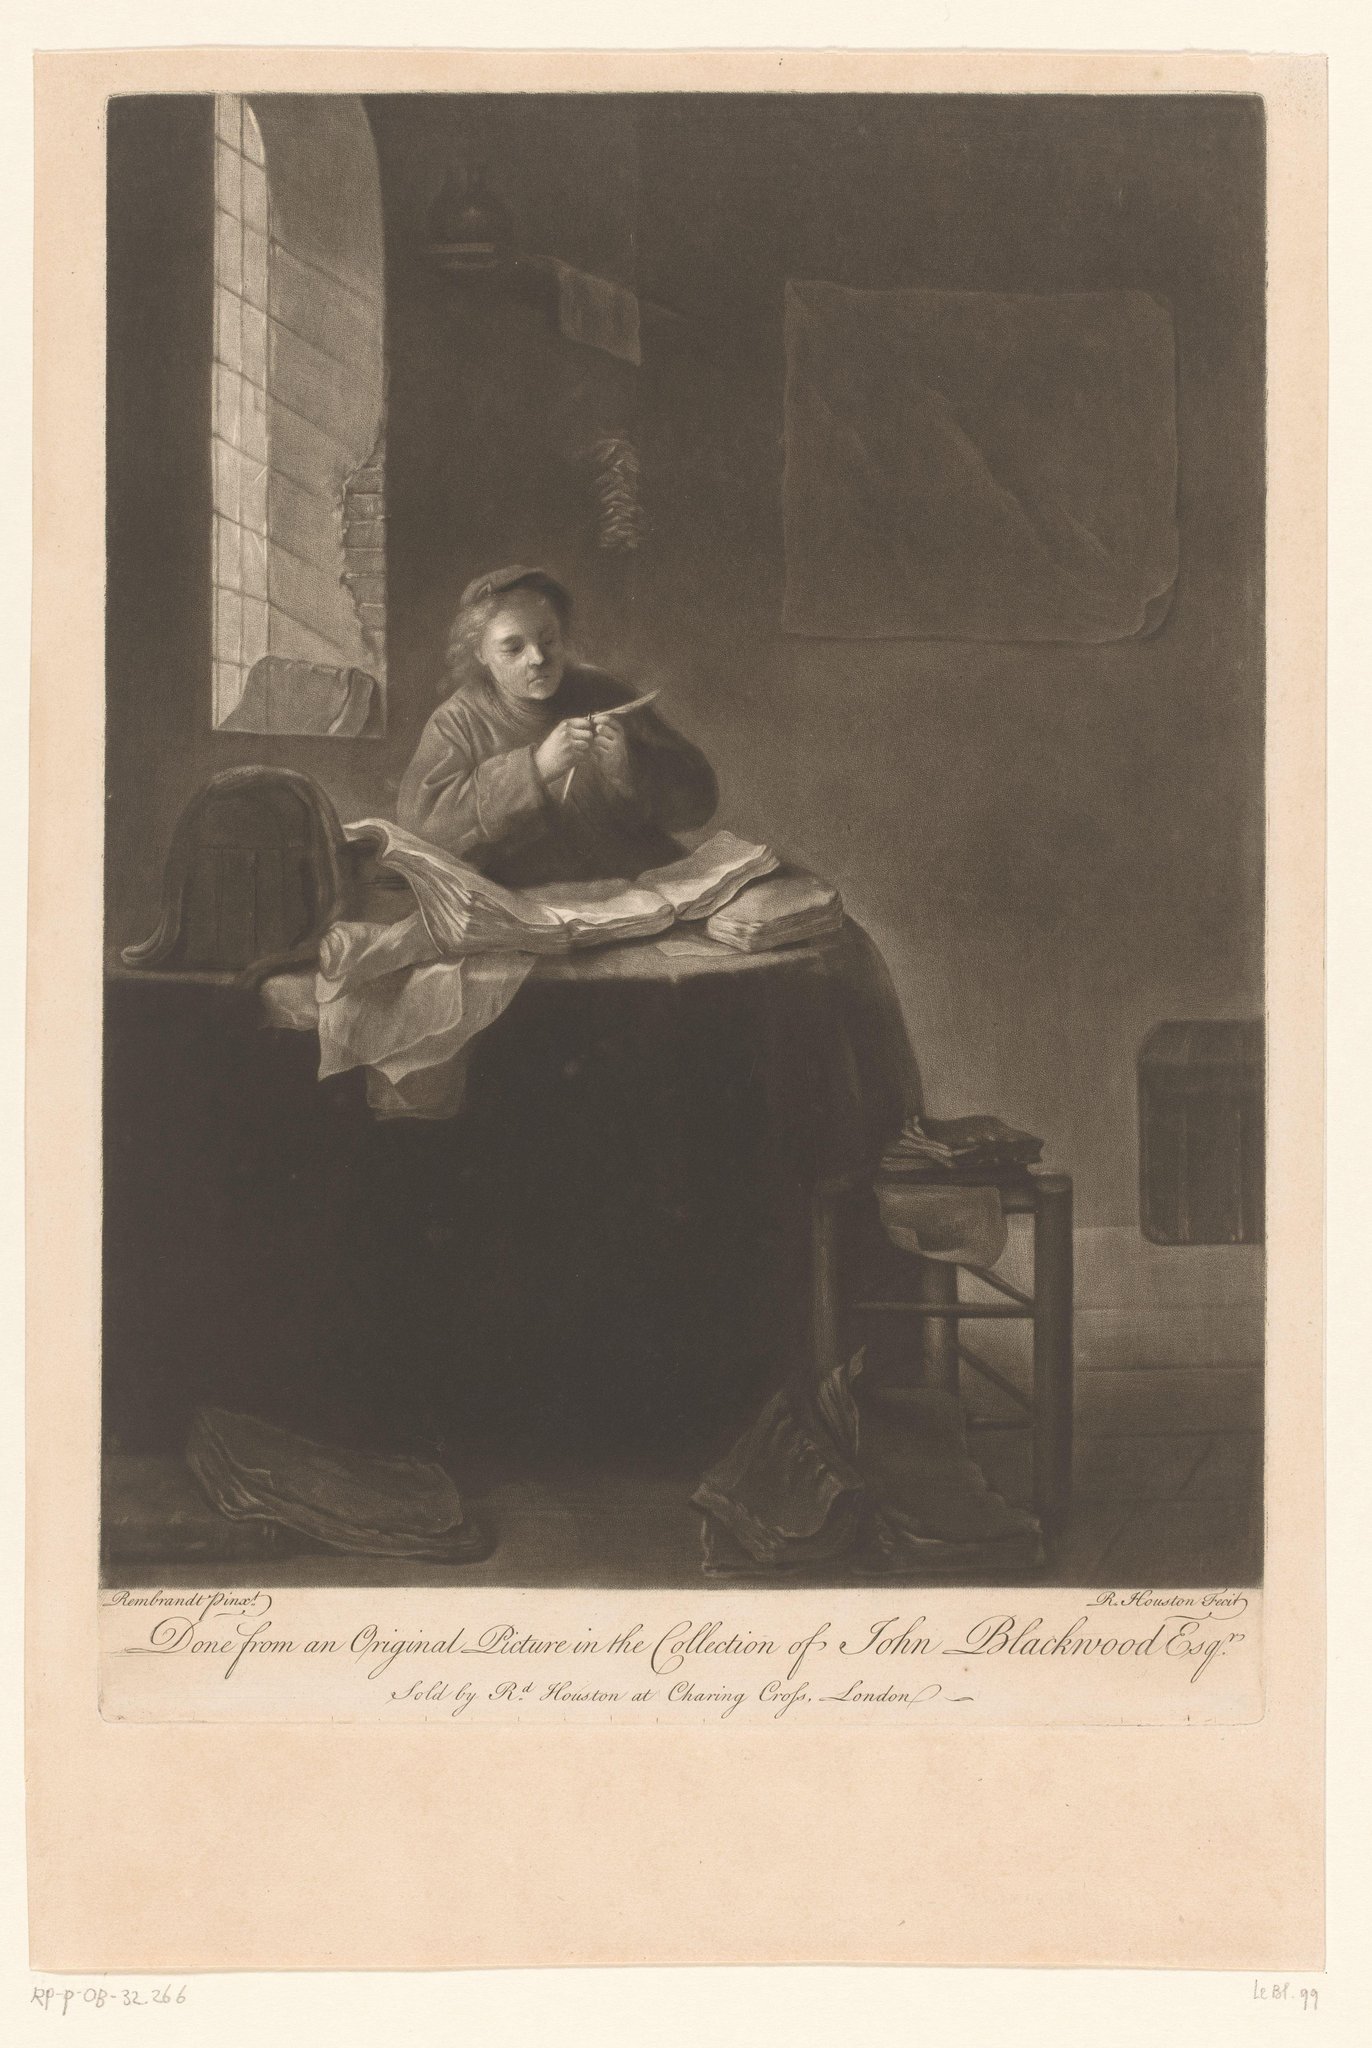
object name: print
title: Geleerde versnijdt een pen in zijn werkkamer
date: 1731-1775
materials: paper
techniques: mezzotint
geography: london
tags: scholar in his study, study; 'studiolo'; library, sharpening pen (quill)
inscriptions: collector's mark: Lugt 240